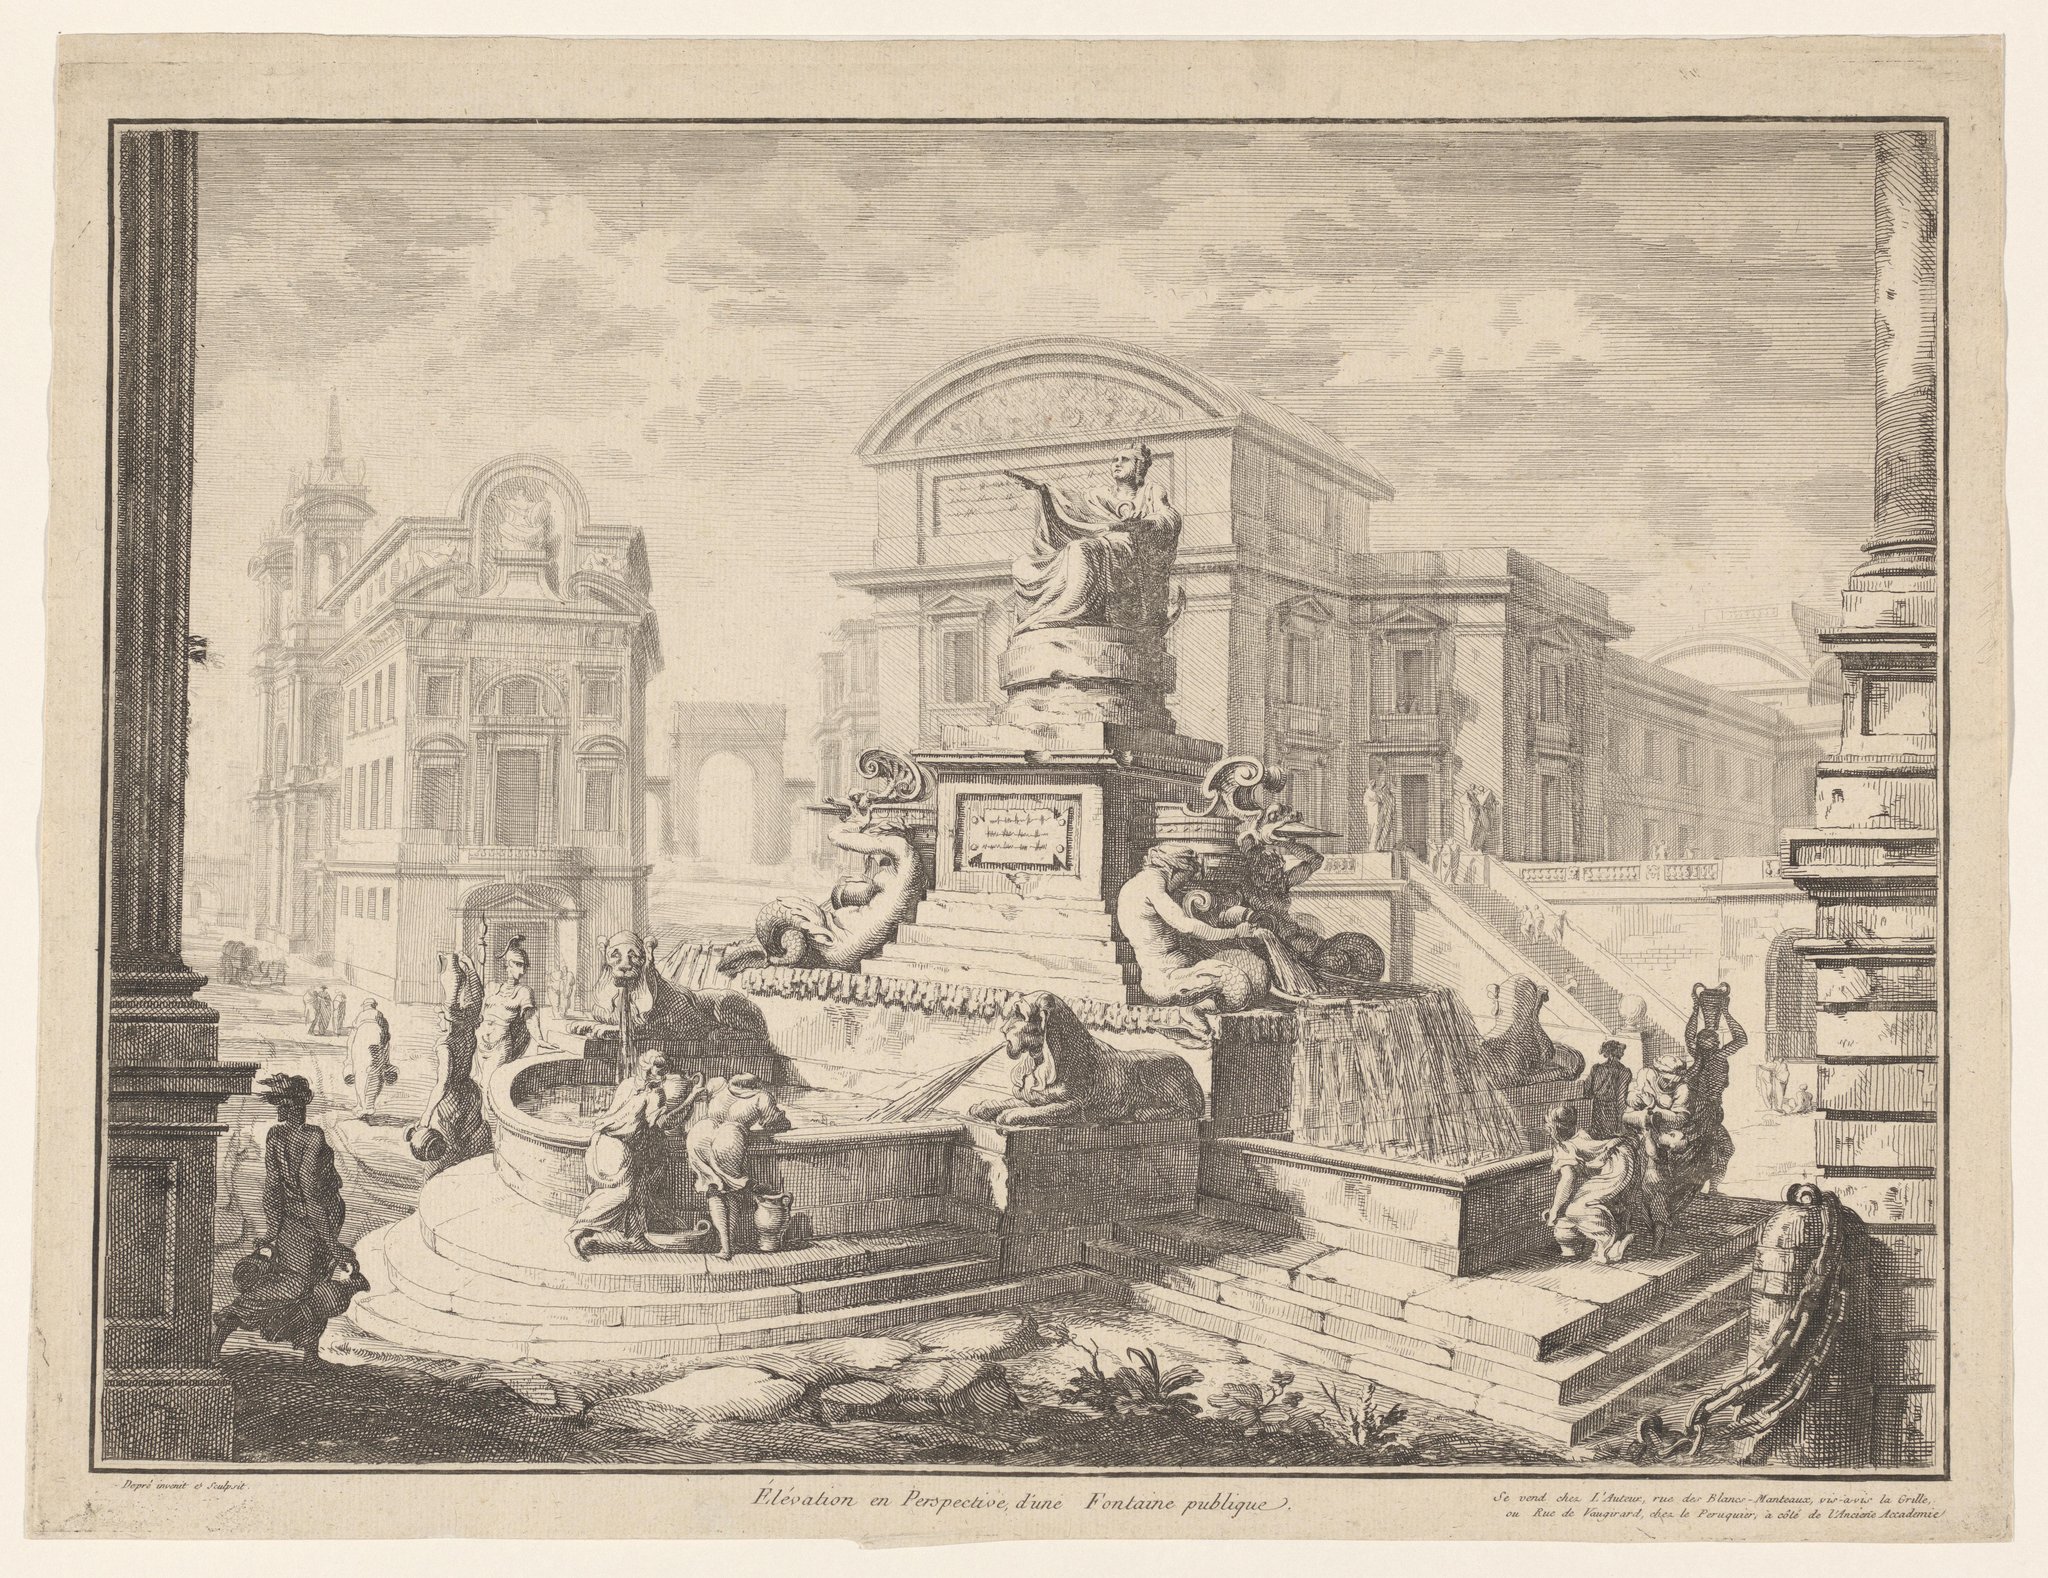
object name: print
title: Élévation en Perspective, d'une Fontaine publique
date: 1780-1789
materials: ink, paper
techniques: etching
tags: ornamental fountain, utilitarian, public pump or water fountain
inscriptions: collector's mark: Lugt 2228, collector's mark: Lugt 2760